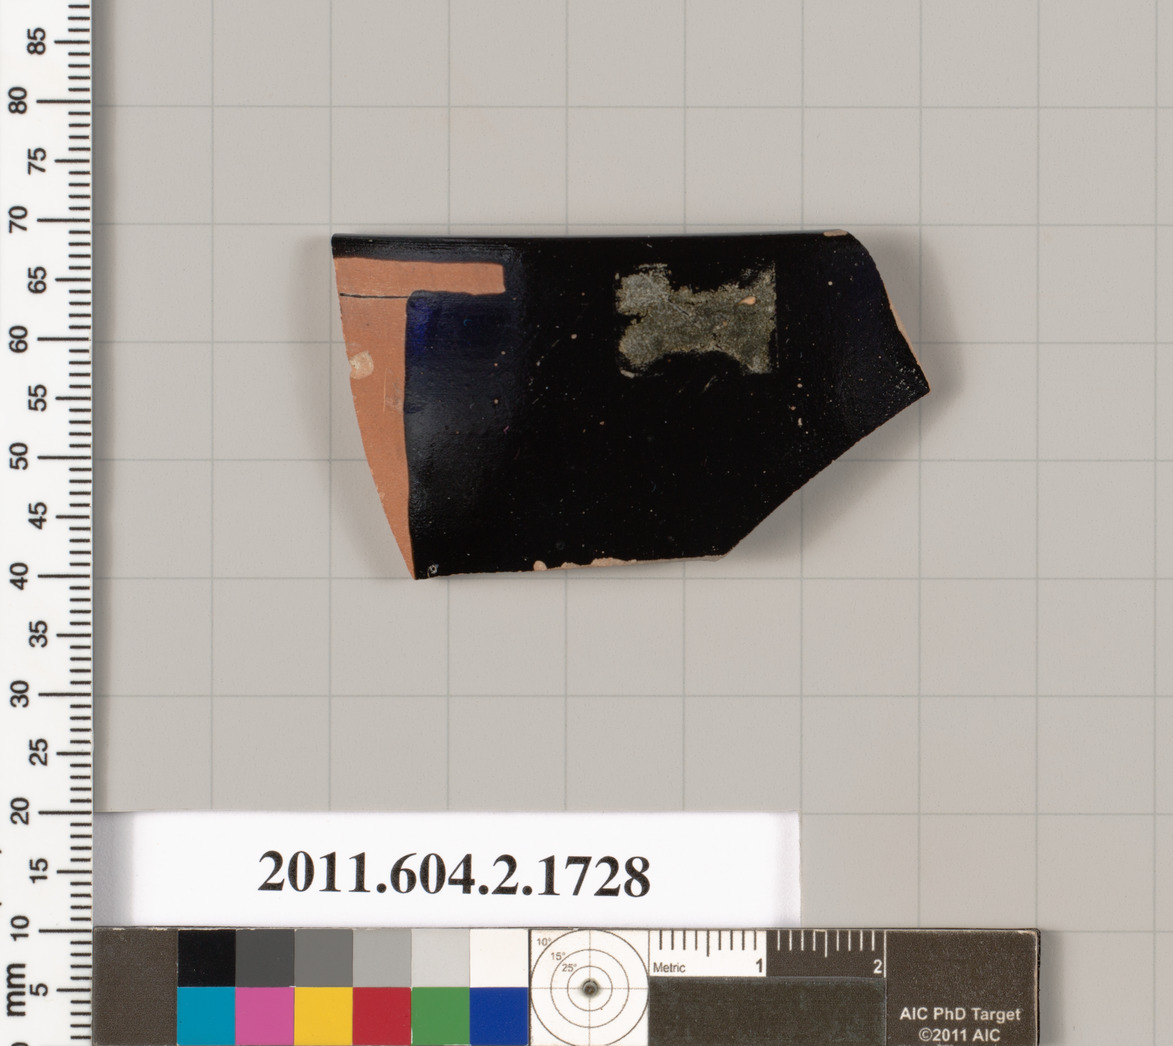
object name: skyphos fragment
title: Terracotta rim fragment of a skyphos (deep drinking cup)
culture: greek, attic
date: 460-440 BCE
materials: terracotta